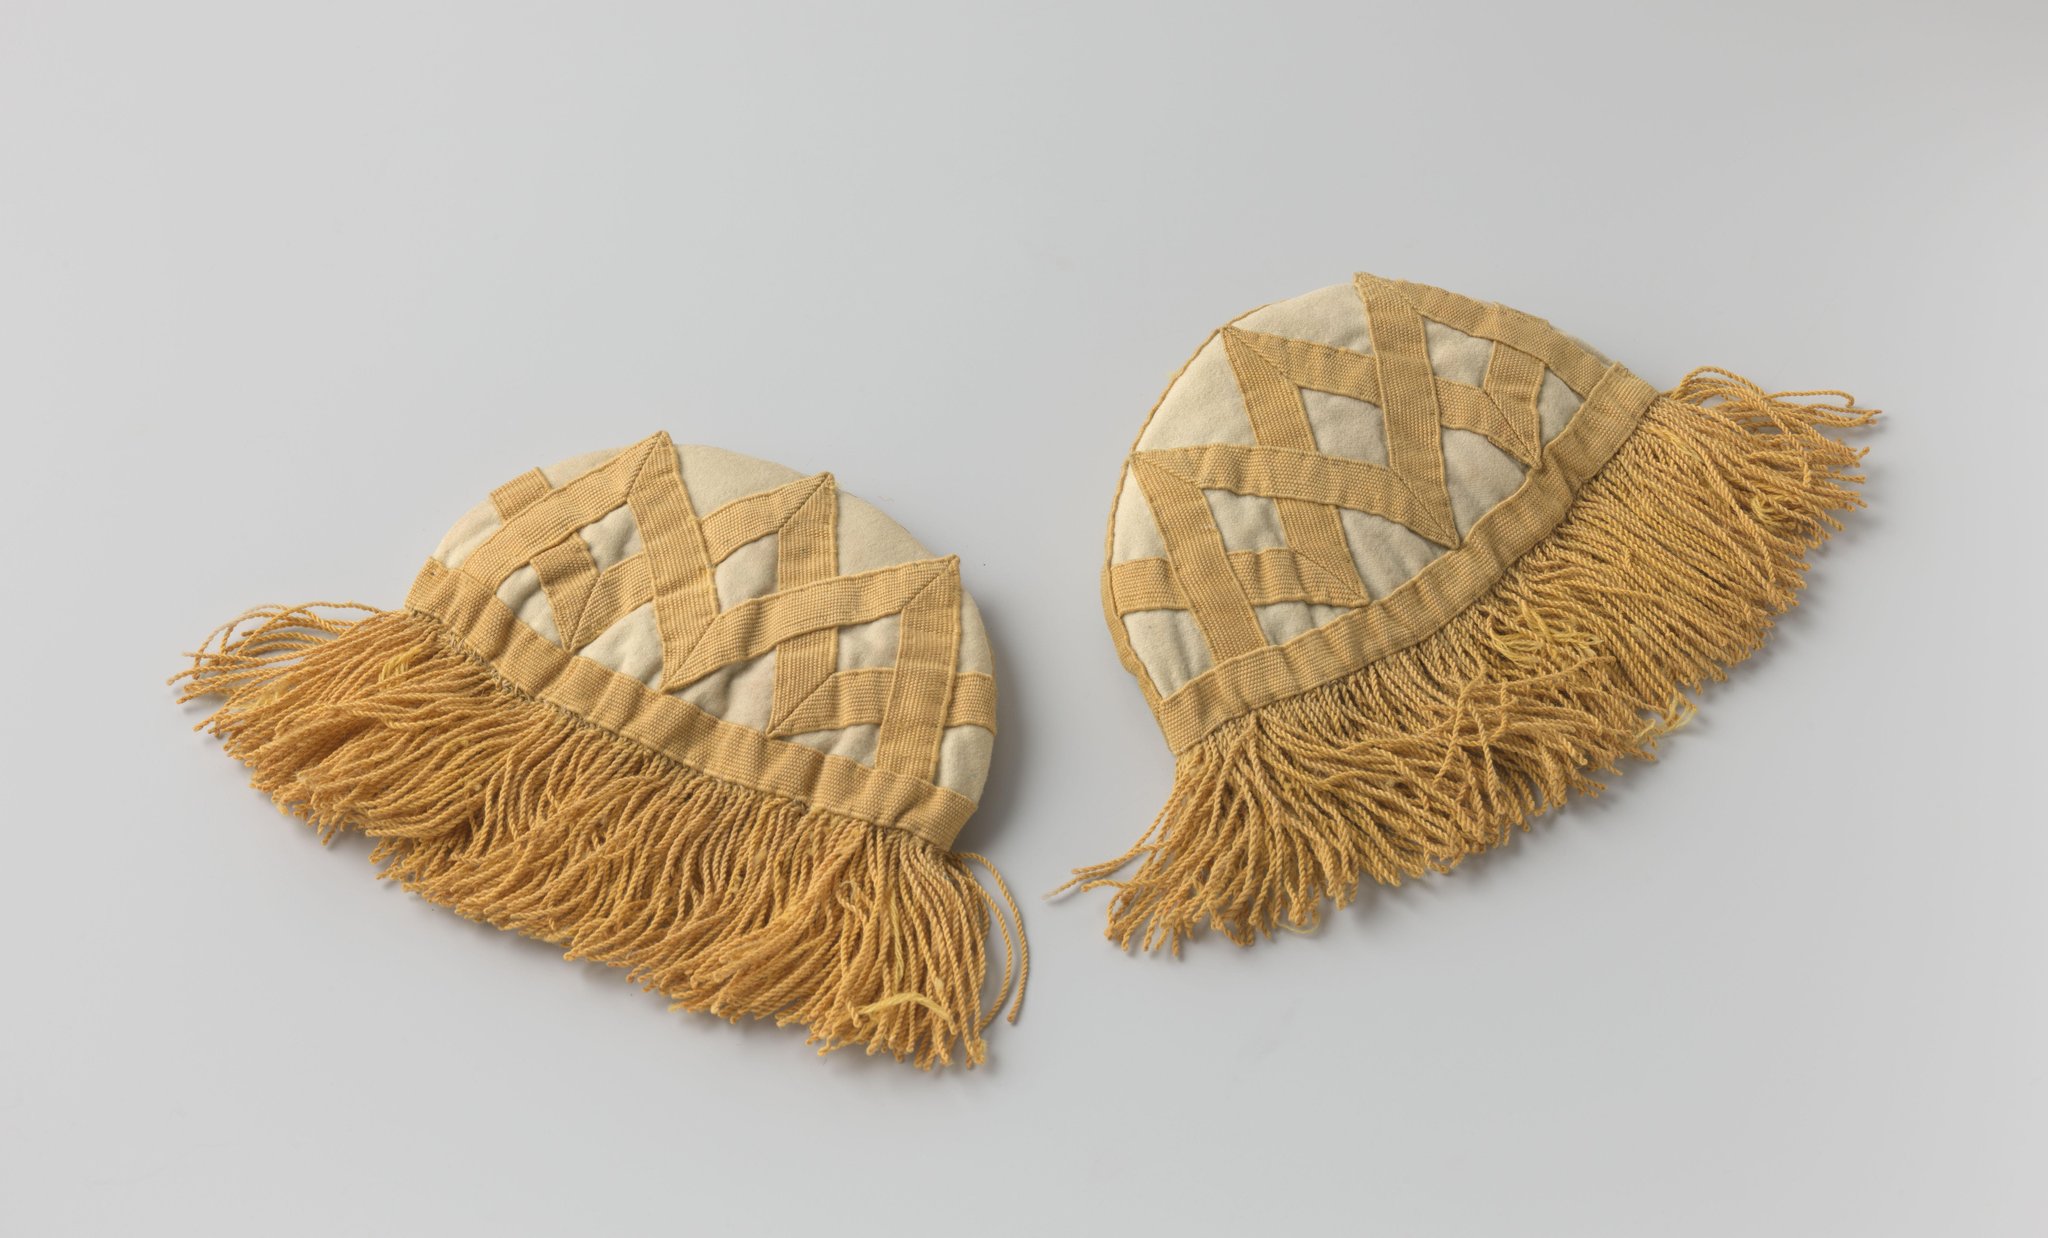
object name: zwaluwnest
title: Pair of Epaulettes for Drummers, Fifers, and Horn Blowers of the Royal Netherlands Army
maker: Anonymous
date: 1825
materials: textile, linen, wool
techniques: stitching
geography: netherlands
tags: netherlands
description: Paar zwaluwnesten voor tamboers, pijpers, hoornblazers der nationale infanterie. Een halfronde wit lakense schouder bedekking, met verschoten gele galons afgezet, dito gekruiste galons op het witte laken. Buitenmodel blauwgrijze voering (gewatteerd). Beschadigd gele franje.